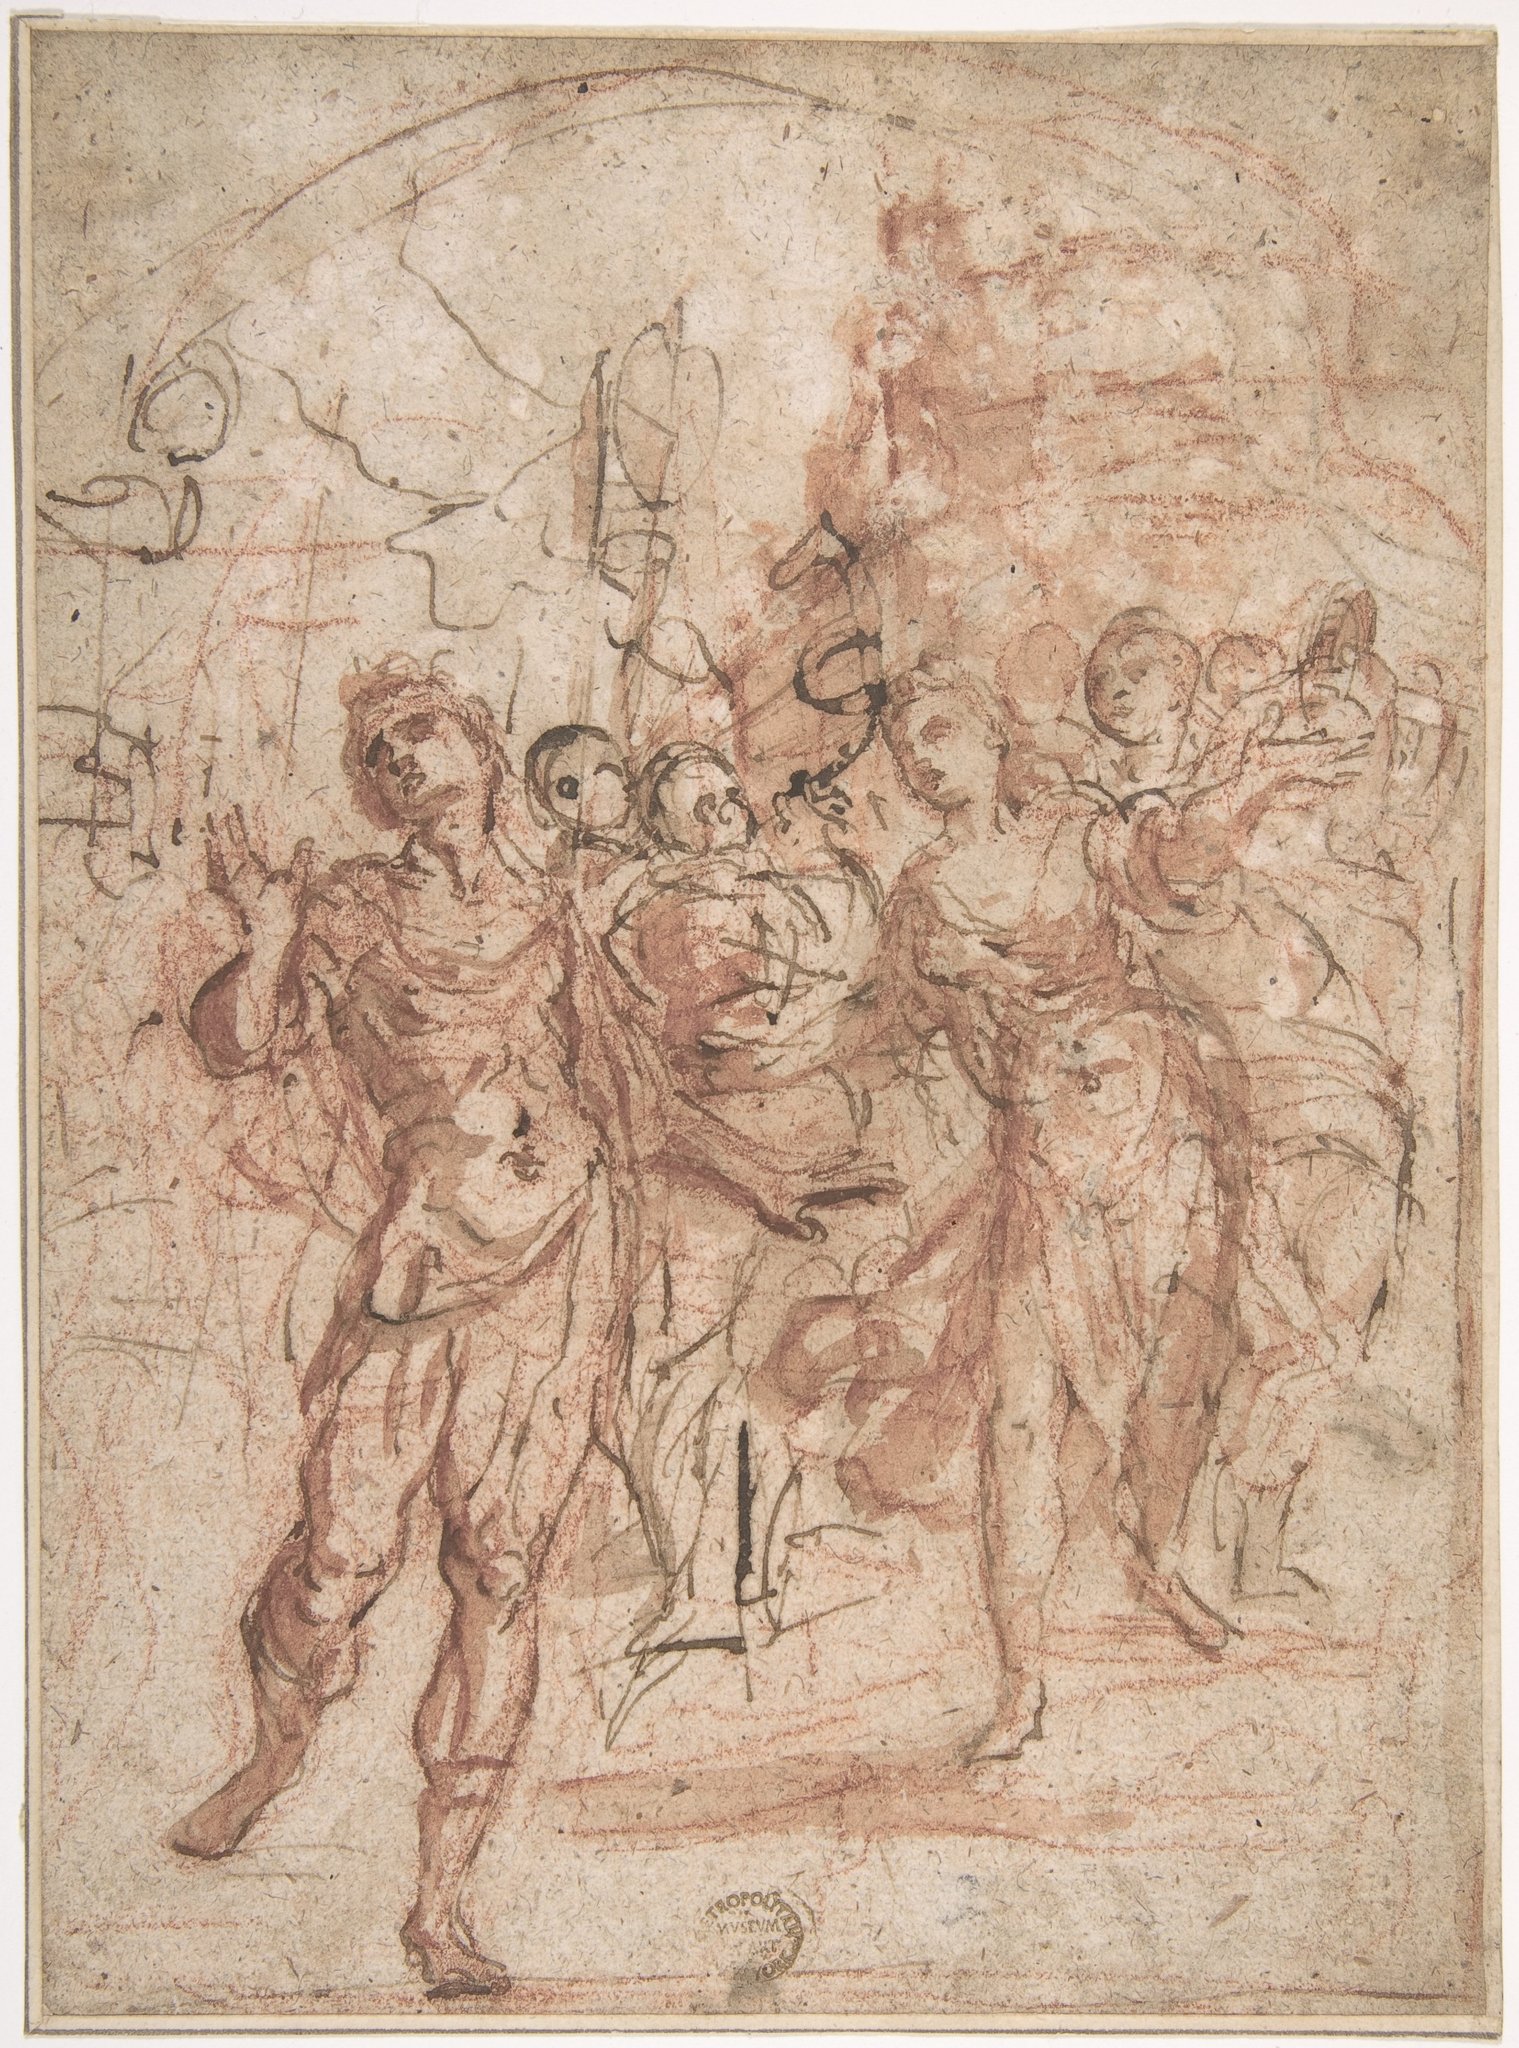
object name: drawing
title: Scene of Celebration with Dancing and Music-Making (Jephtha and his Daughter?)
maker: anonymous, italian, roman-bolognese, 17th century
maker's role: artist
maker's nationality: italian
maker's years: 1600-1700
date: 1680-1720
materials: chalk, ink, paper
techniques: brush, pen, wash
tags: men,women,dancing